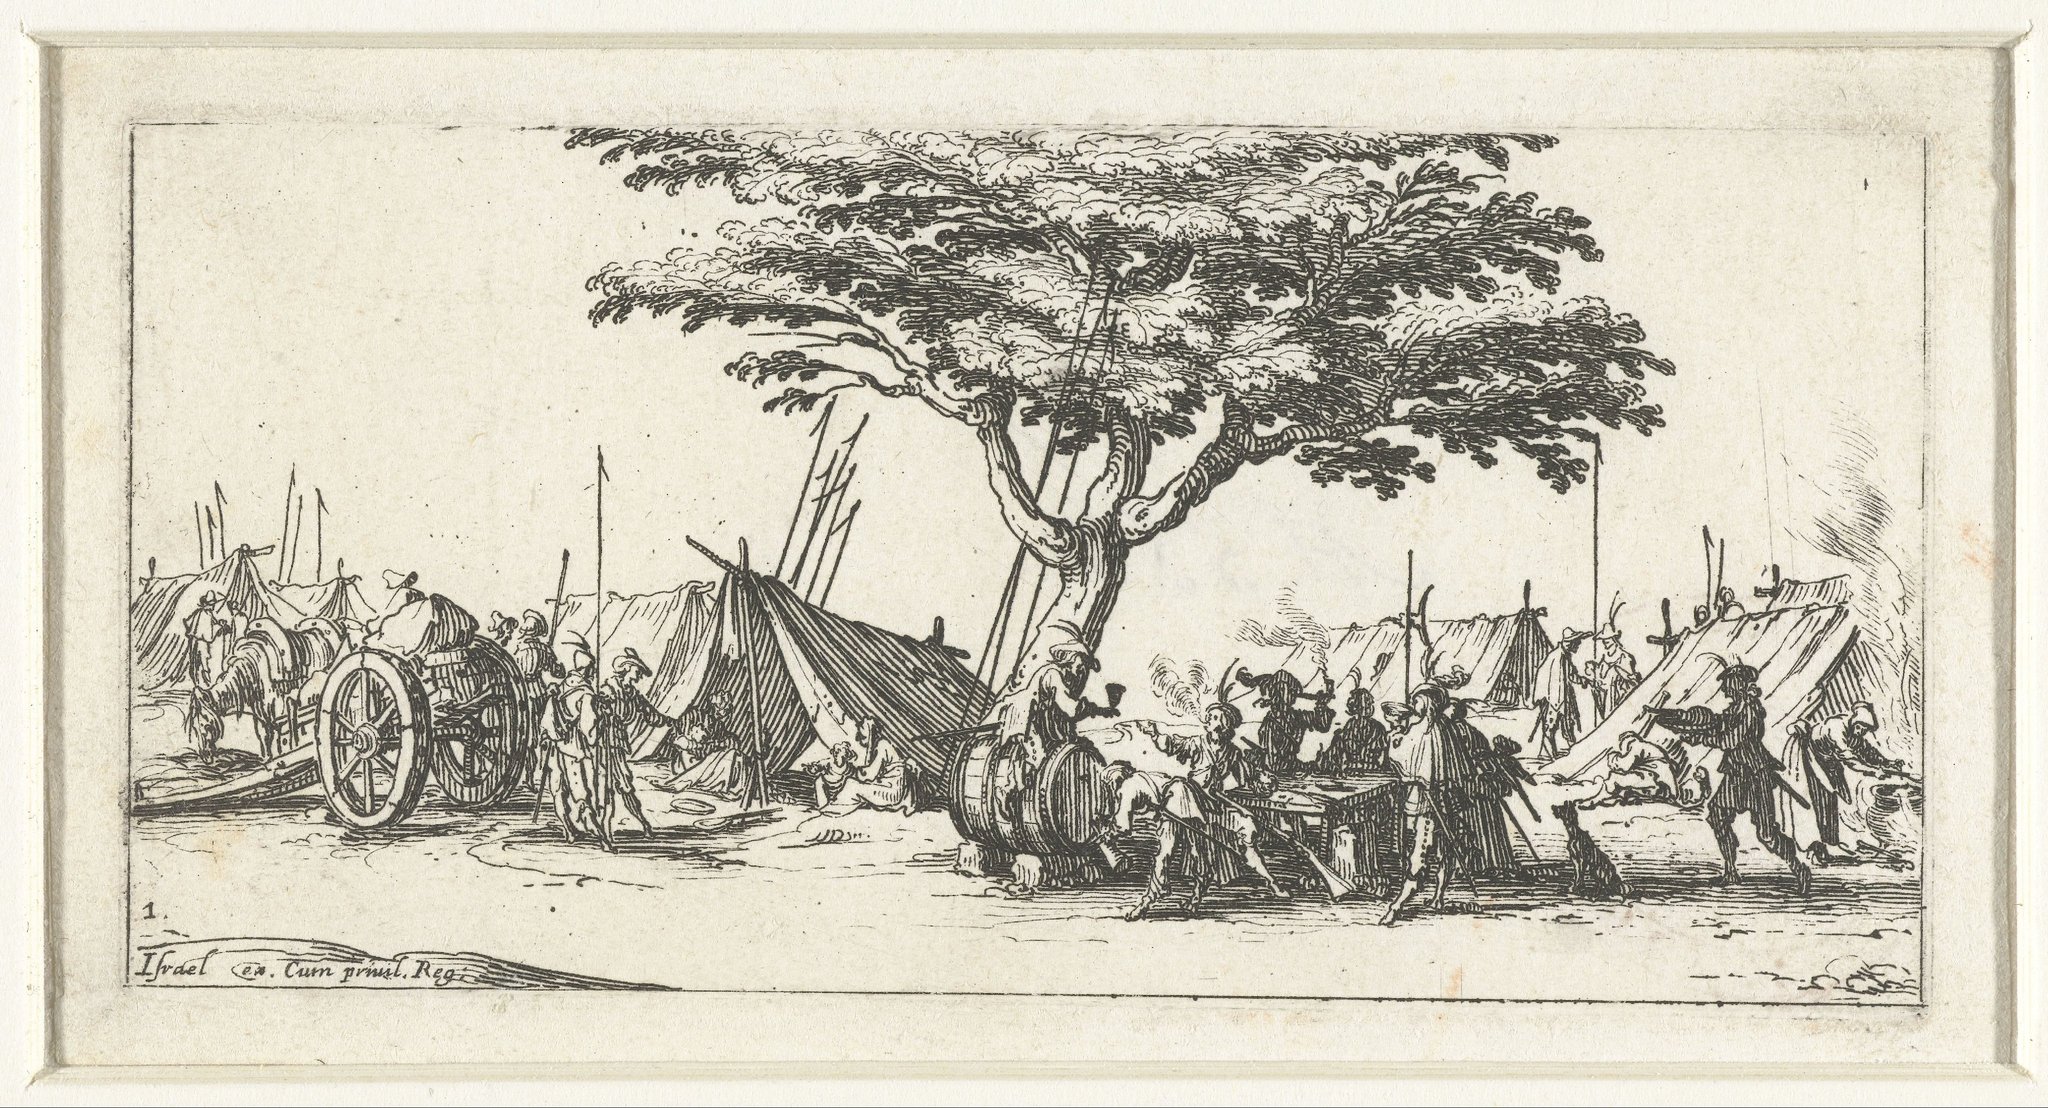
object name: print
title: Legerkamp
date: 1632-1636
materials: paper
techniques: etching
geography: nancy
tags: (military) camp with tents, soldiers in gay company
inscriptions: collector's mark: Lugt 240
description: Bij een boom, omringd door tenten, staat een tafel waaraan soldaten drinken en roken. Deze prent is onderdeel van een serie van zes (zeven incl. titelprent) kleine prenten met voorstellingen van diverse soorten ellende die oorlogvoering met zich meebrengt.